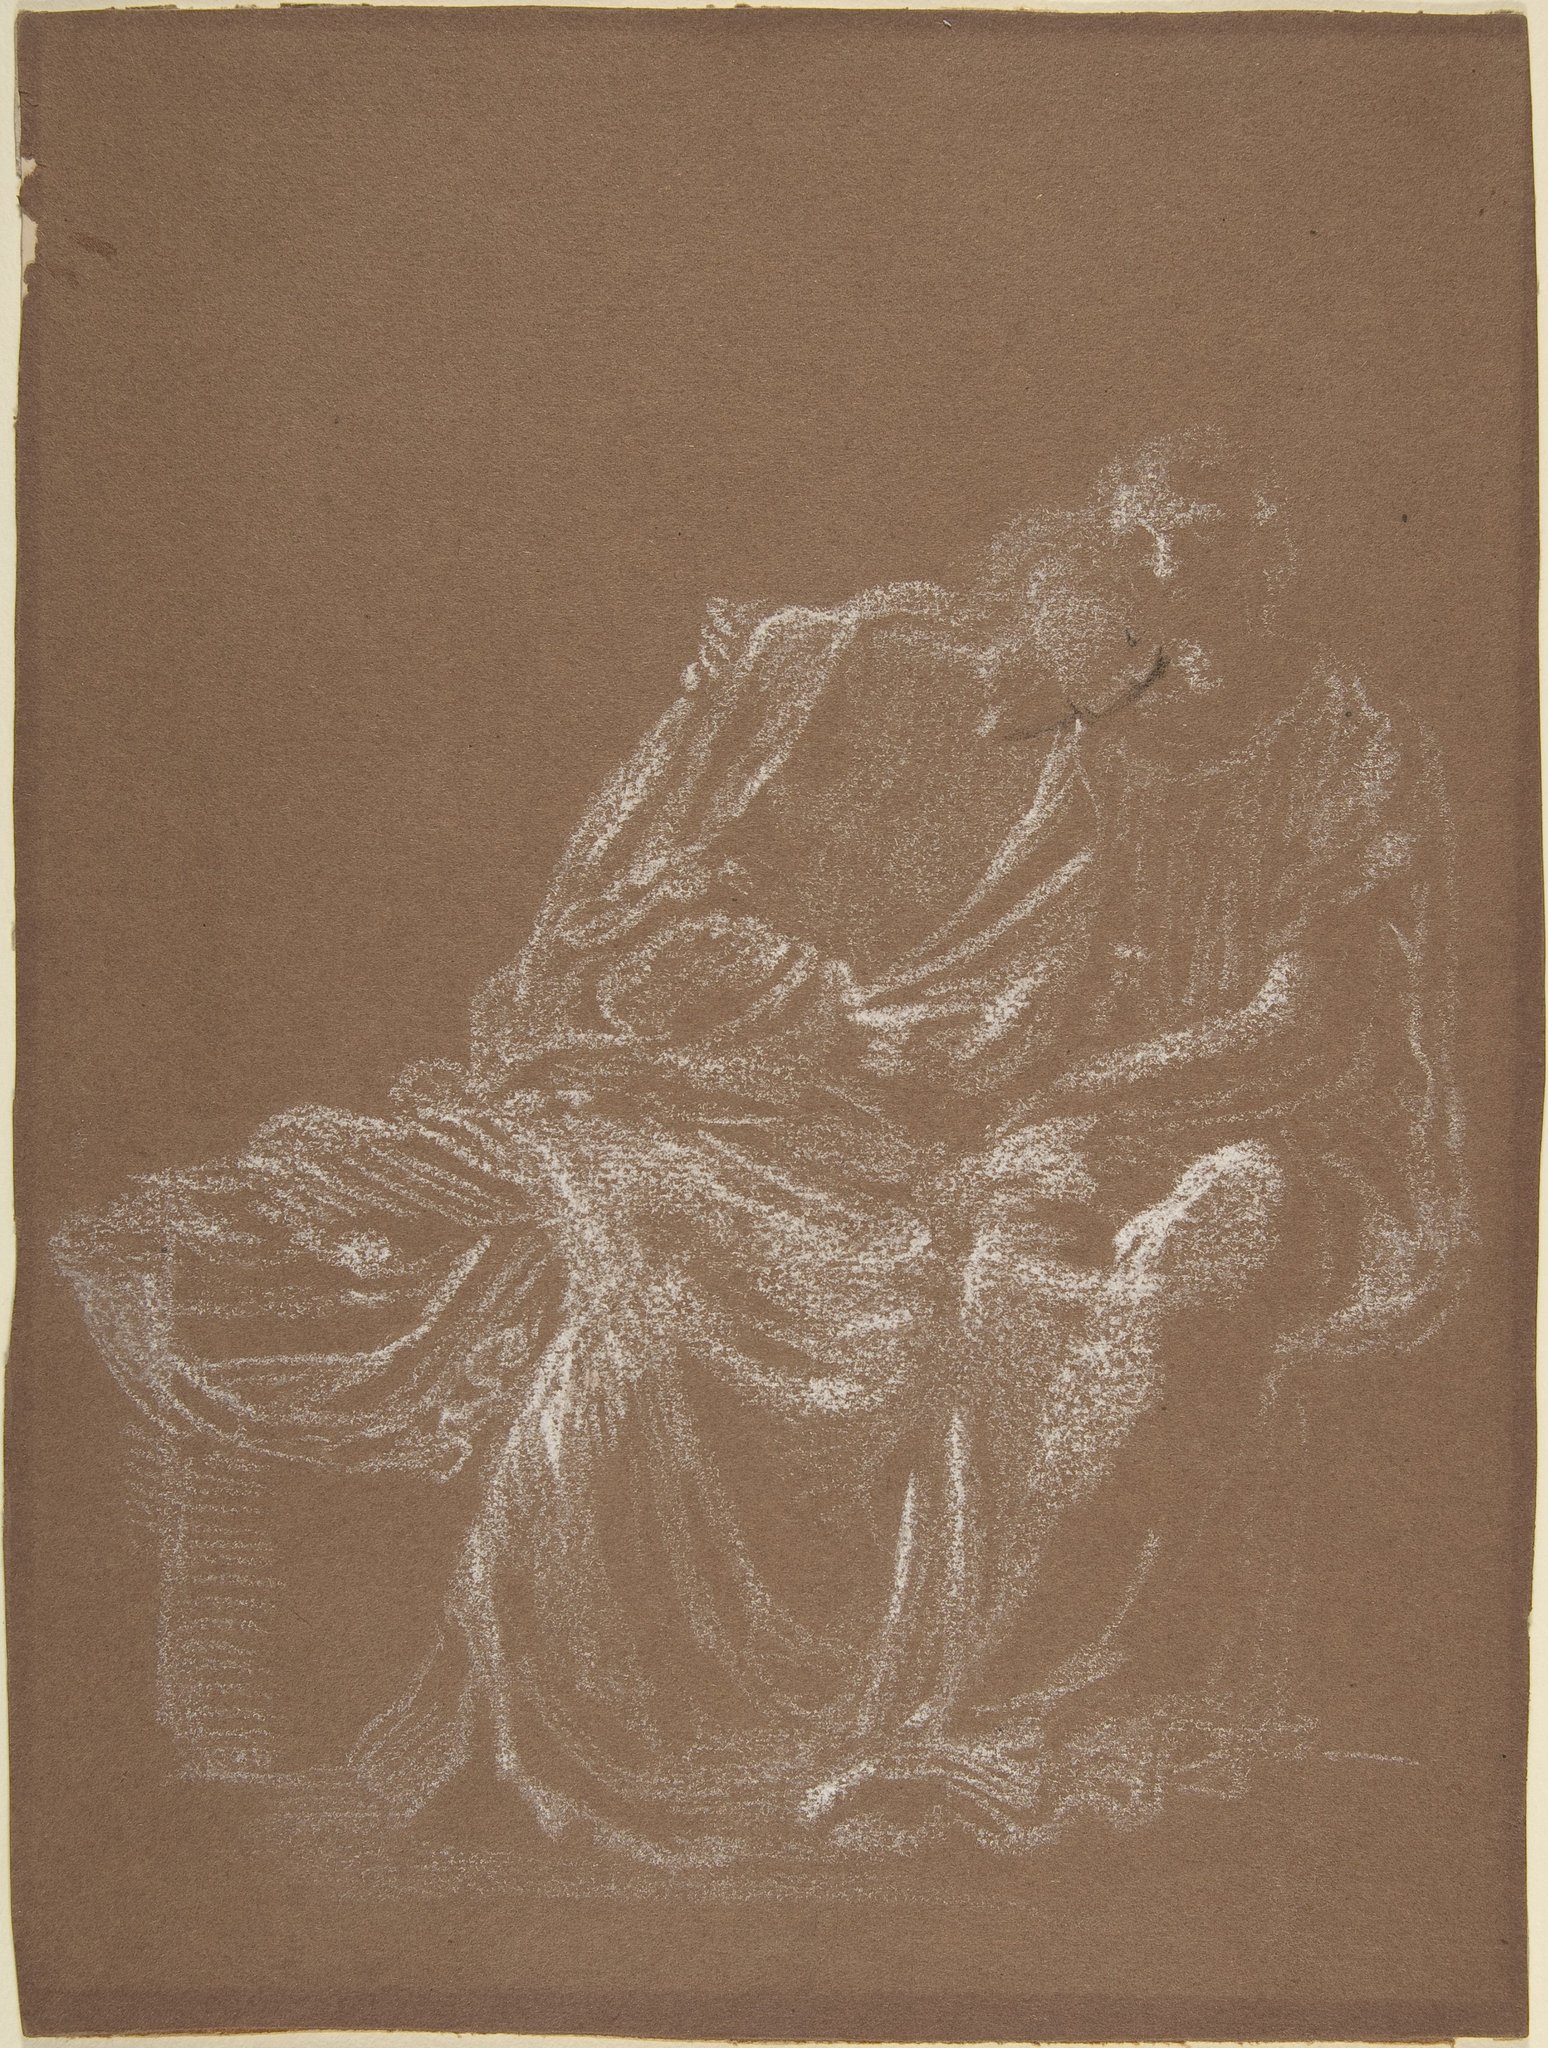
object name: drawing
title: A seated couple, embracing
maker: sir edward burne-jones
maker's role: artist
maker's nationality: british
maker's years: 1833-1898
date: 1865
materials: chalk, graphite, paper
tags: couples,men,women